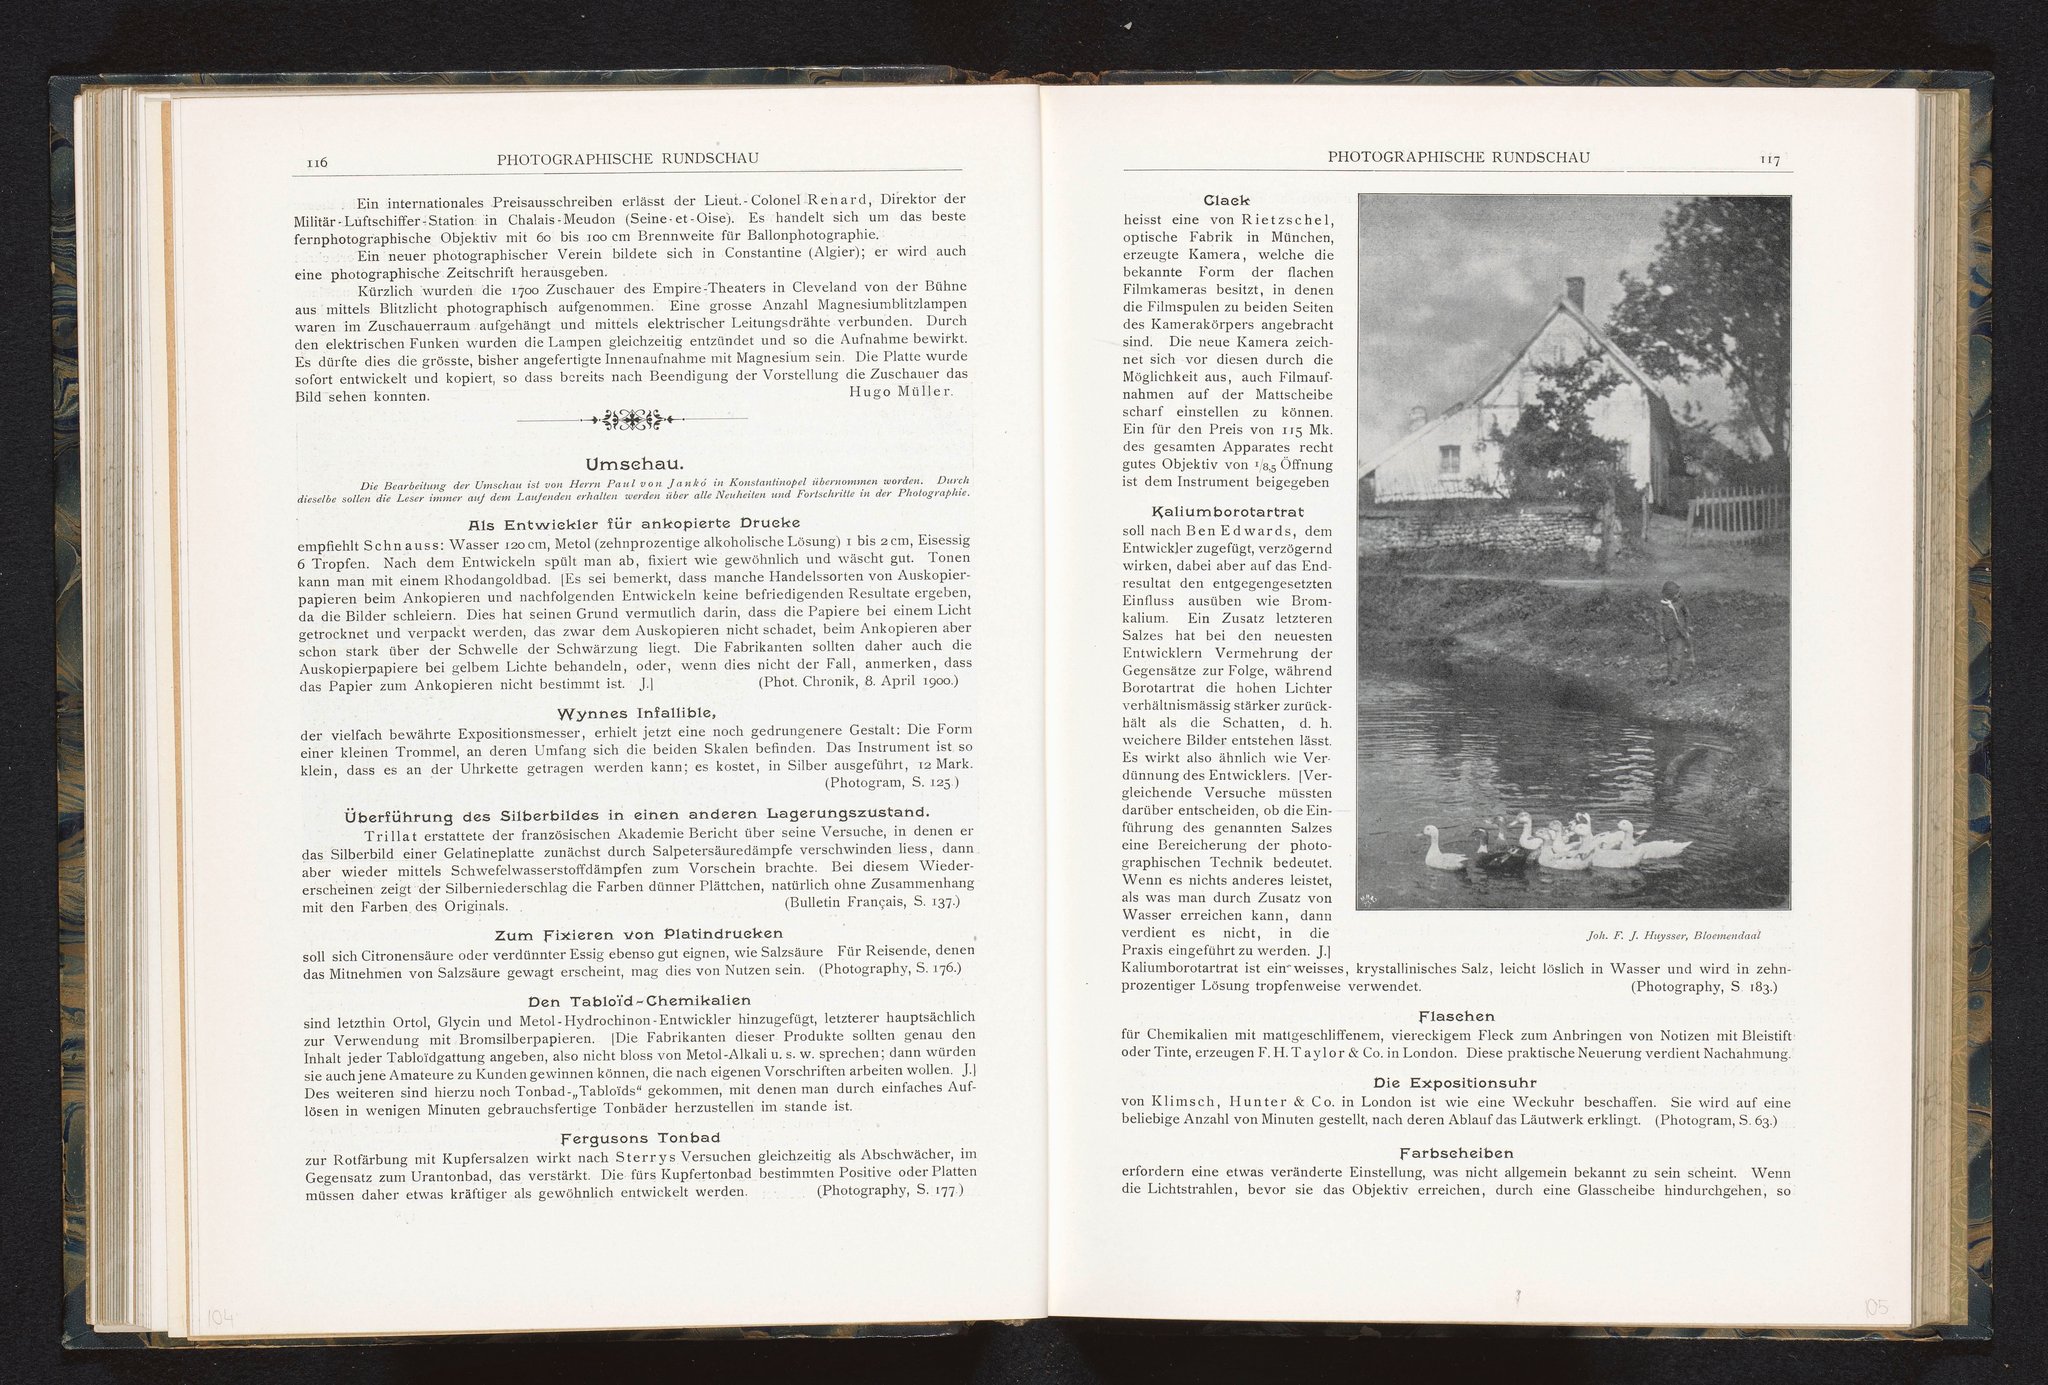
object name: photomechanical print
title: Gezicht op een onbekend kind aan een water met eenden en op de achtergrond een huis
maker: johan huijsser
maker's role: fotograaf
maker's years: 1868-1924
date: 1895-1900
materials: paper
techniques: autotype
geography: berlin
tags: child, rural housing, e.g. country-house, villa, cottage, water-birds: duck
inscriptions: monogram: ‘MR&C’